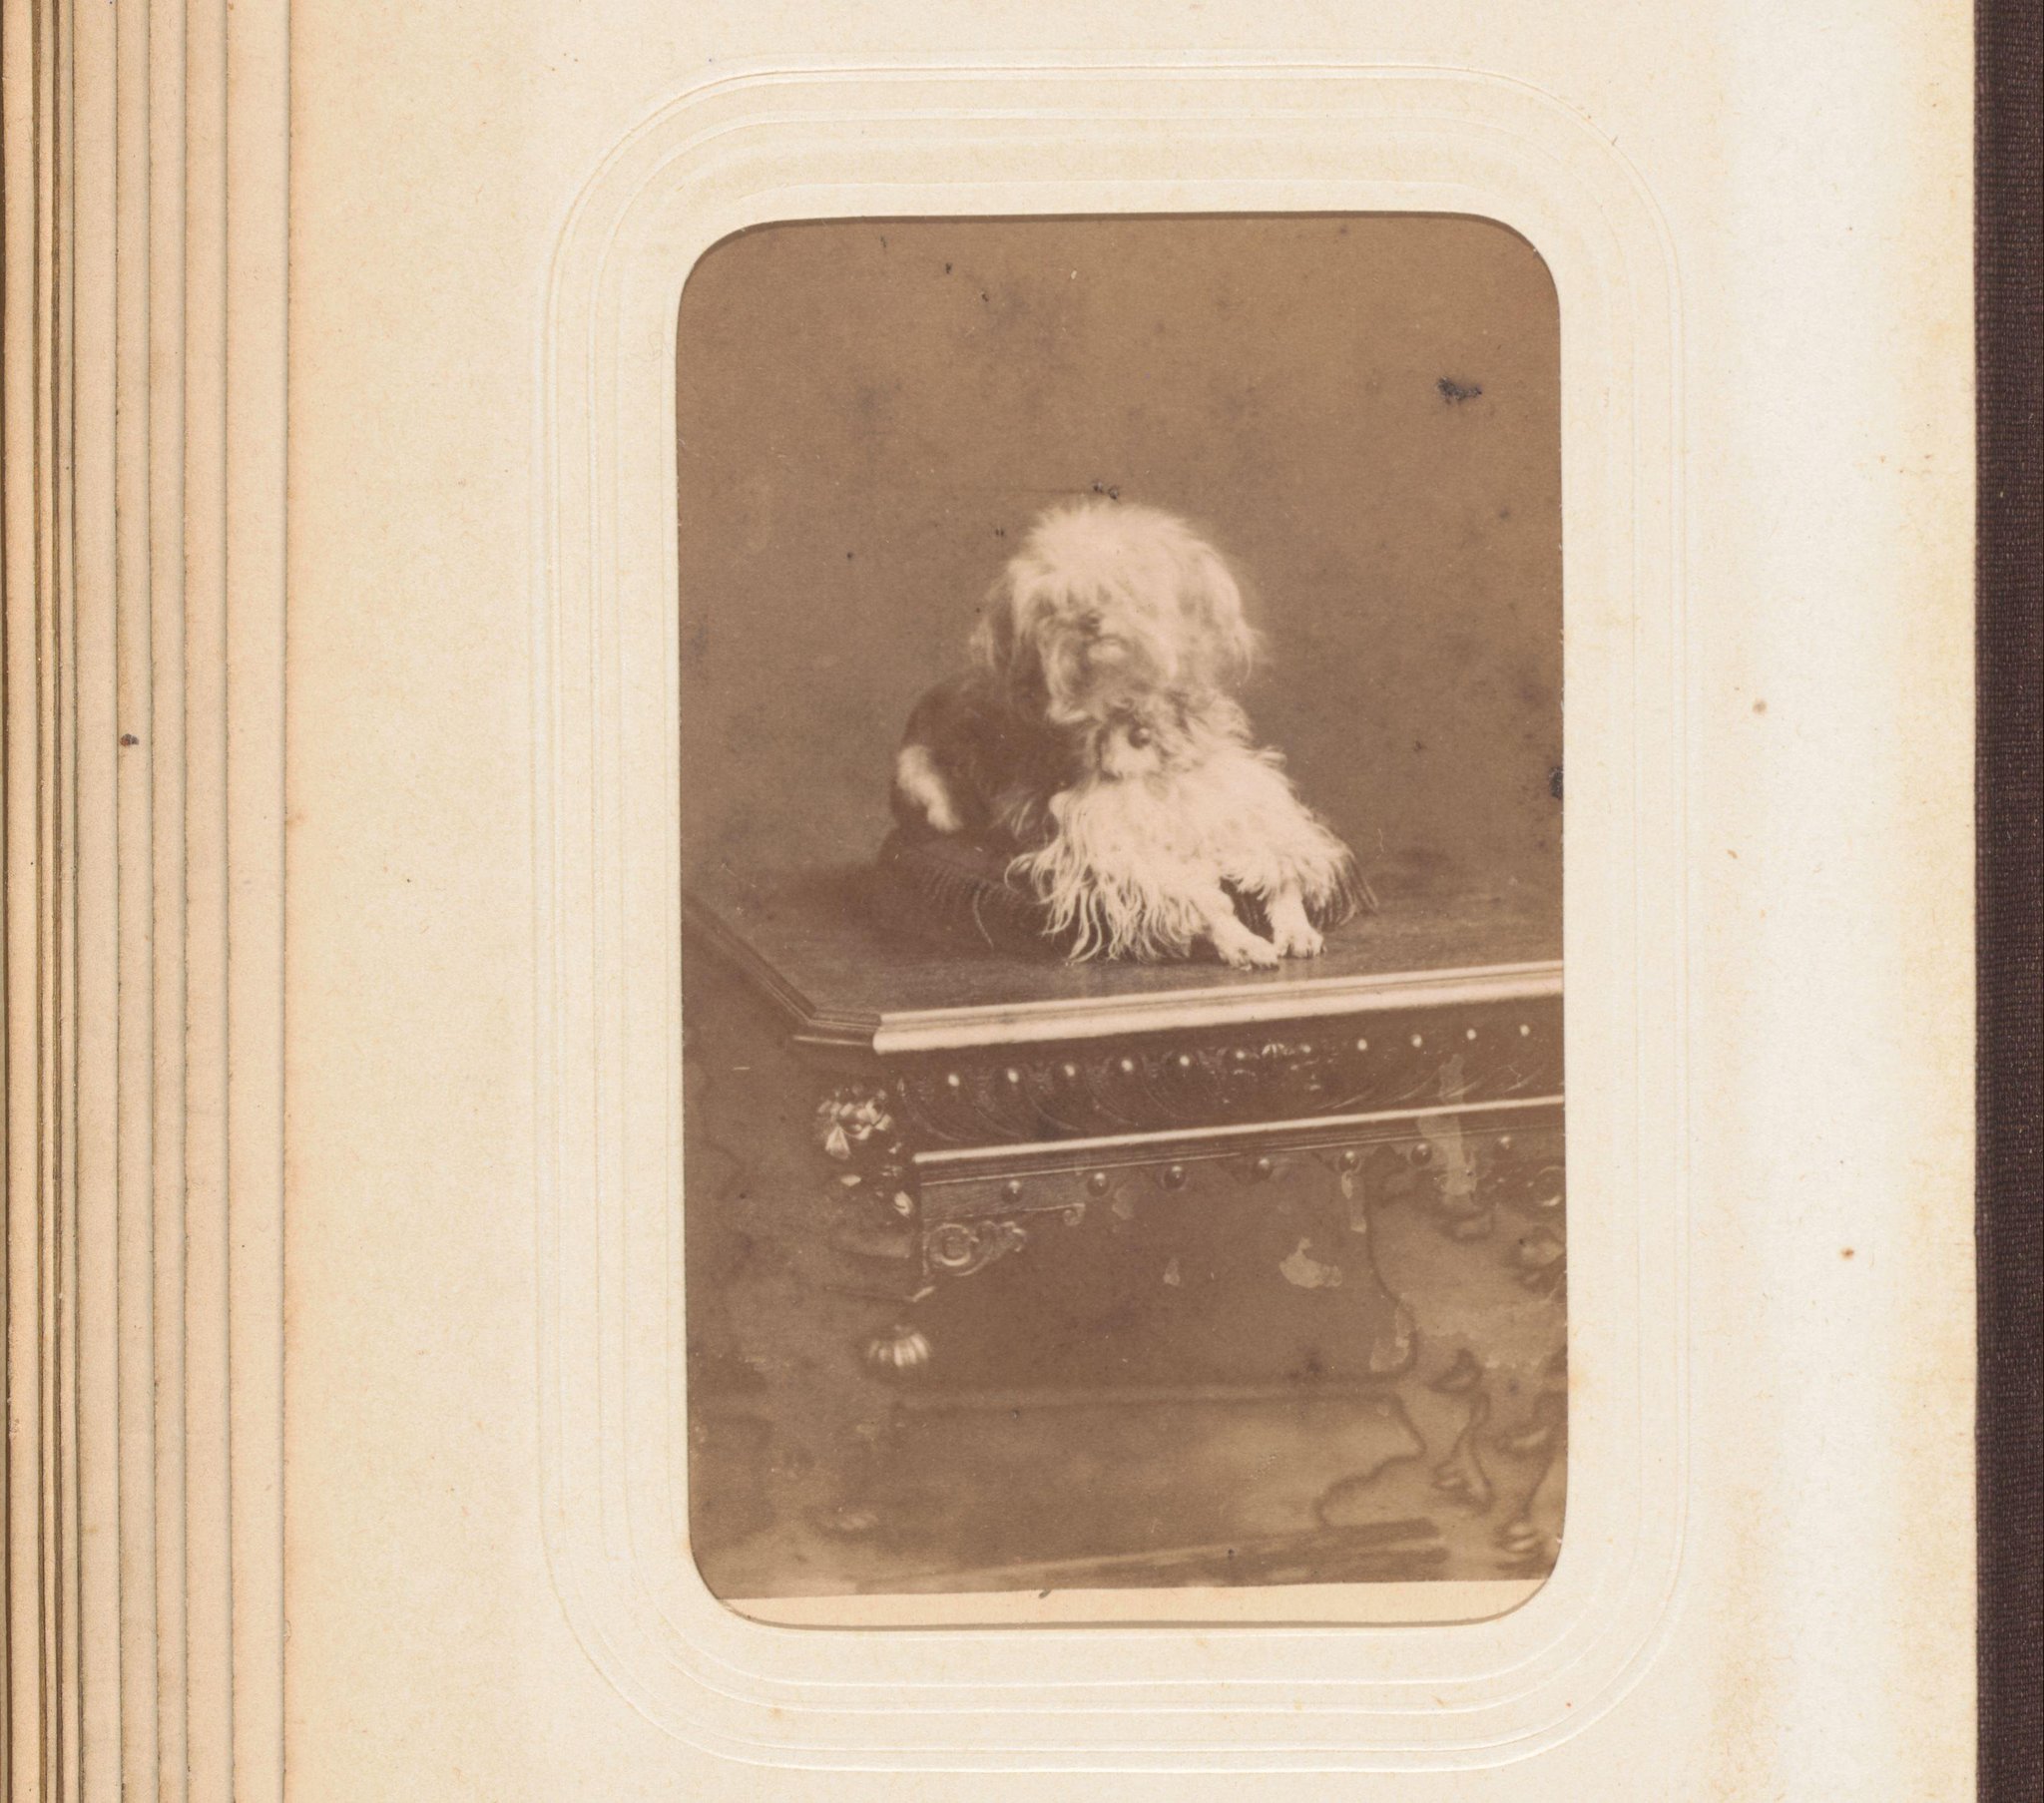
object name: carte de visite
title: Portret van een hond op een lage tafel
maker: albert greiner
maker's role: fotograaf, fotostudio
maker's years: 1833-1890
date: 1870-1890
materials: cardboard, photographic support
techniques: albumen print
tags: dog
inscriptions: inscription: ‘A. Greiner/ Photograaf/ (...)’